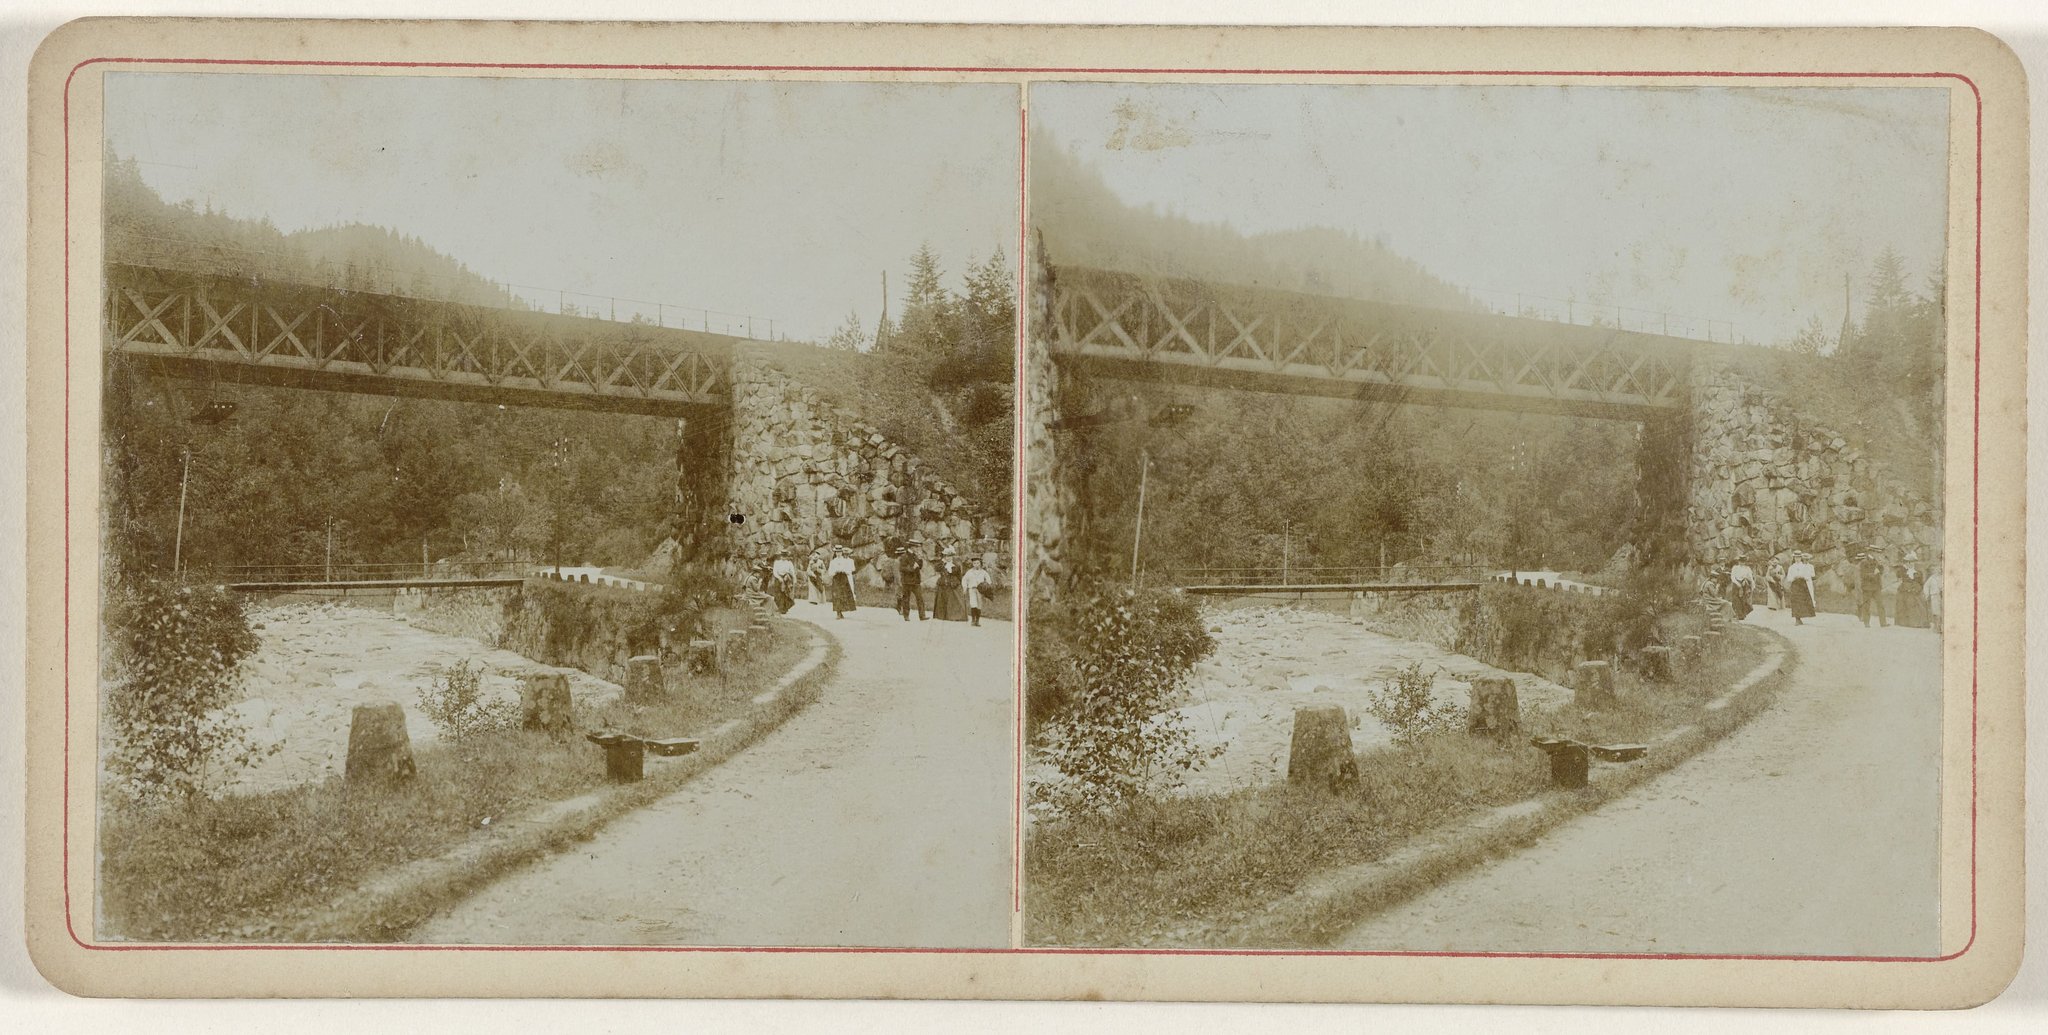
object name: stereograph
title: Wandelend van Homberg naar Friberg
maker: geldolph adriaan kessler (dolph)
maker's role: fotograaf, industrieel, voetballer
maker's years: 1884-1945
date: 1902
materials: paper, photographic support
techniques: collodion silver print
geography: germany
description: Wandelend van Homberg naar Friberg onder de spoorbrug door, over de weg en langs de beek.